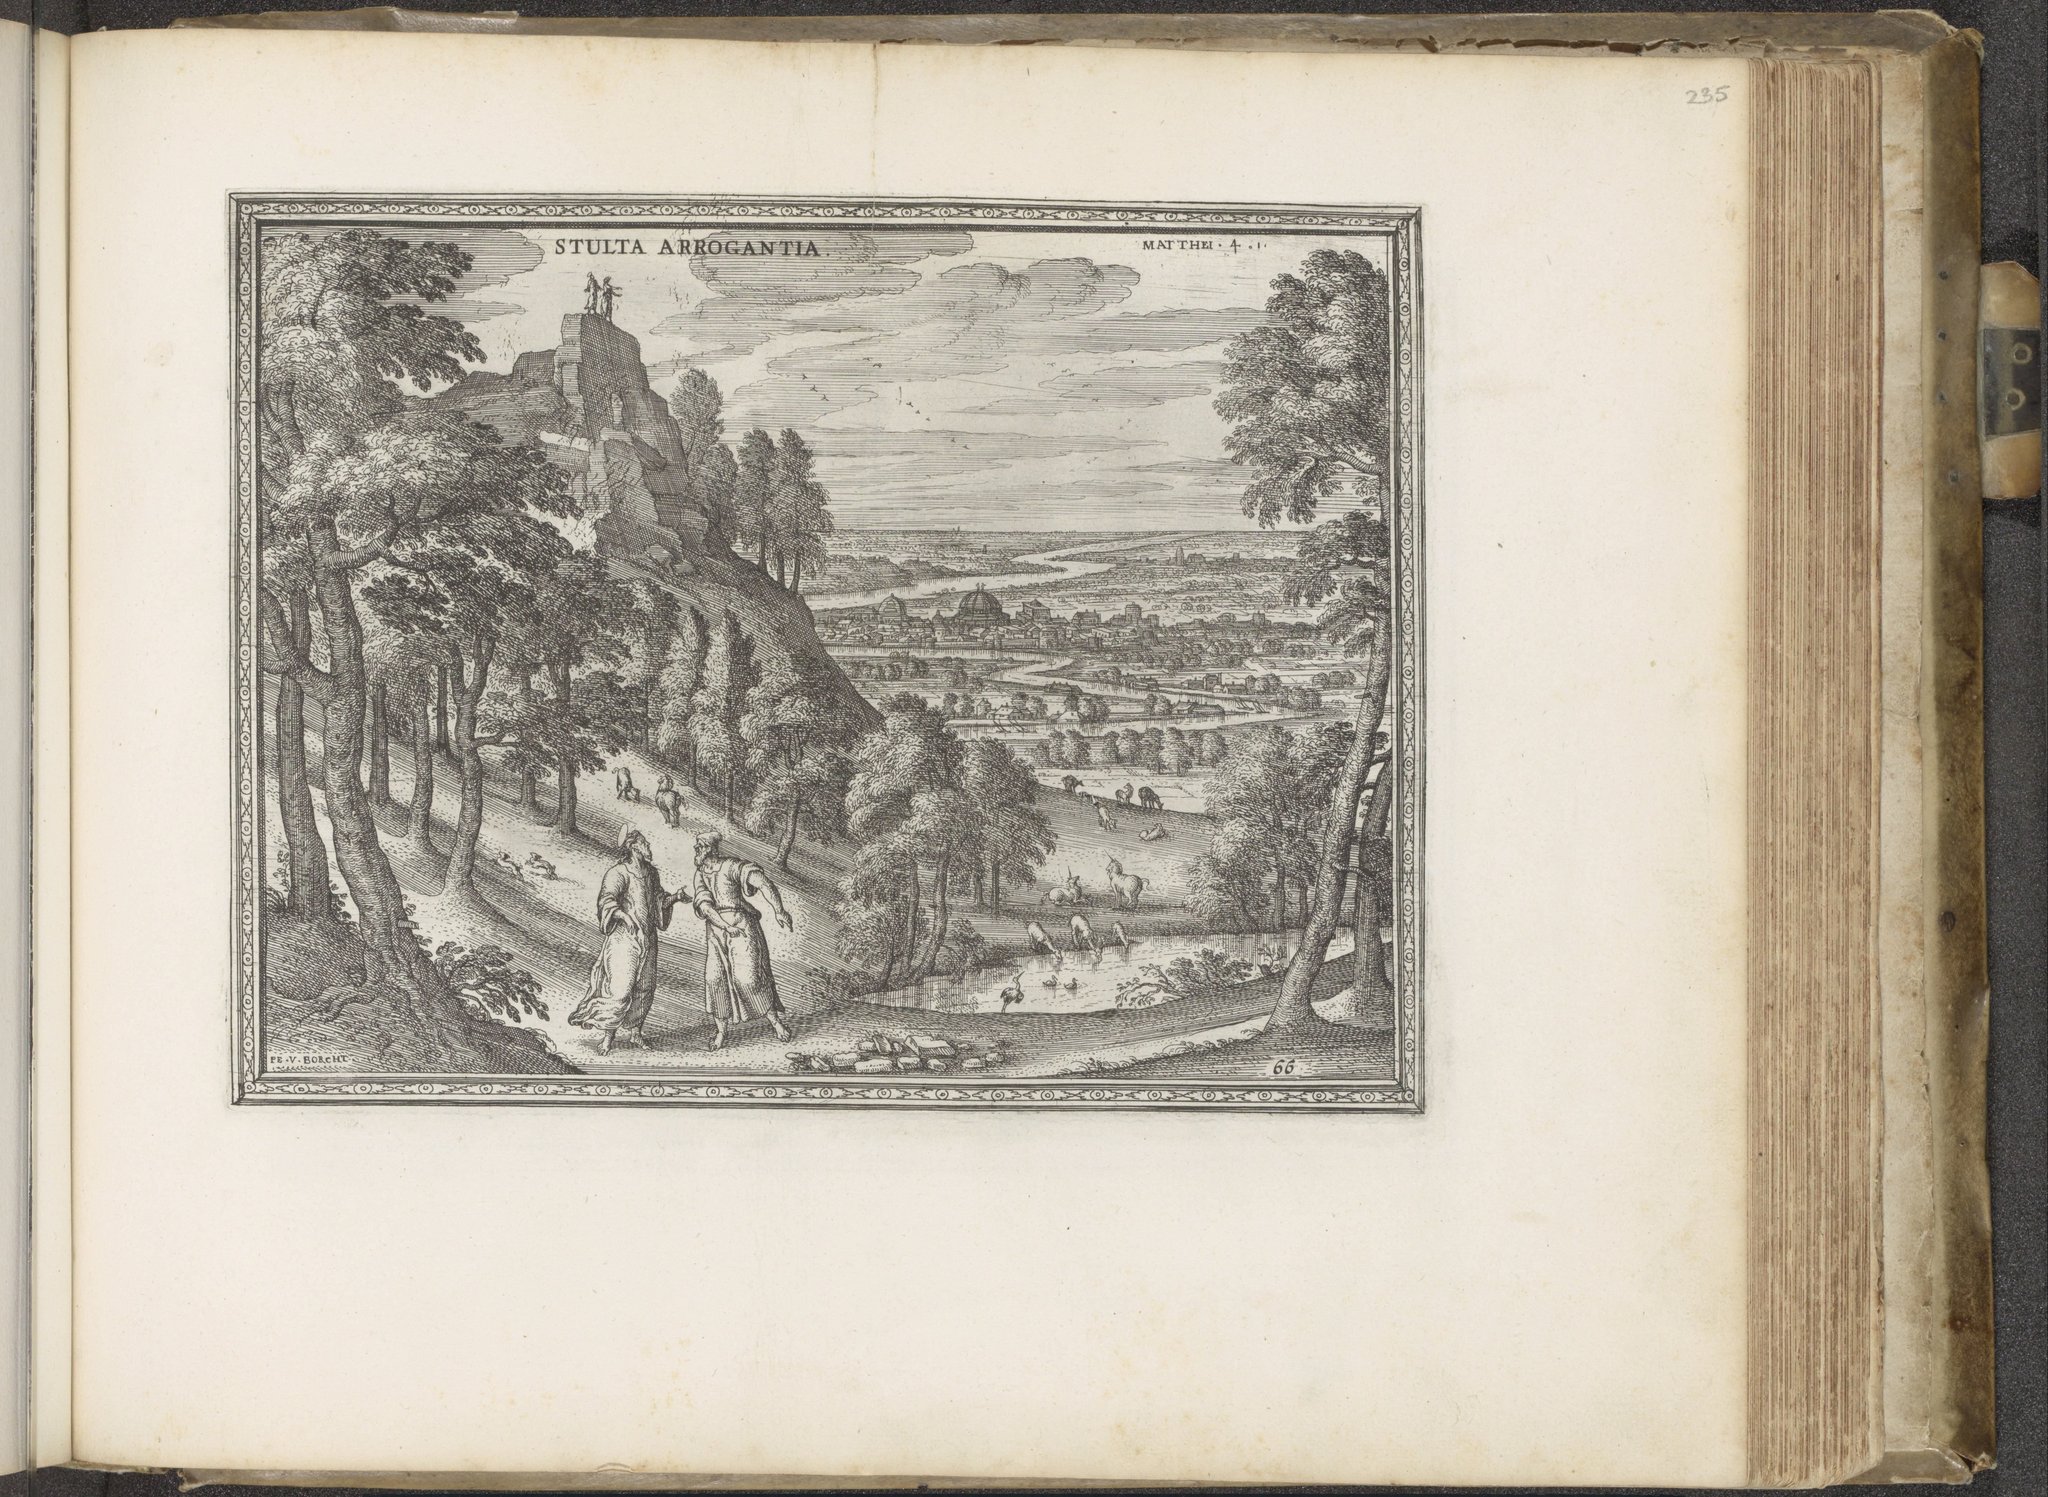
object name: print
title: Imagines et figurae bibliorum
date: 1582-1593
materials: paper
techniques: etching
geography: amsterdam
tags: 'command these stones to become loaves of bread' ~ temptation of christ in the wilderness, water course, forest, wood, 'all these will i give you' (= the glory of the world) ~ temptation of christ in the wilderness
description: Boomrijk rivierlandschap met de Verzoeking van Christus. Op de voorgrond wijst de beproever op een aantal stenen op de grond en daagt Christus uit ze in broden te veranderen. Op de top van de berg belooft hij Christus alle koninkrijken van de wereld (Matt. 4:1-11). De prent maakt deel uit van een album.